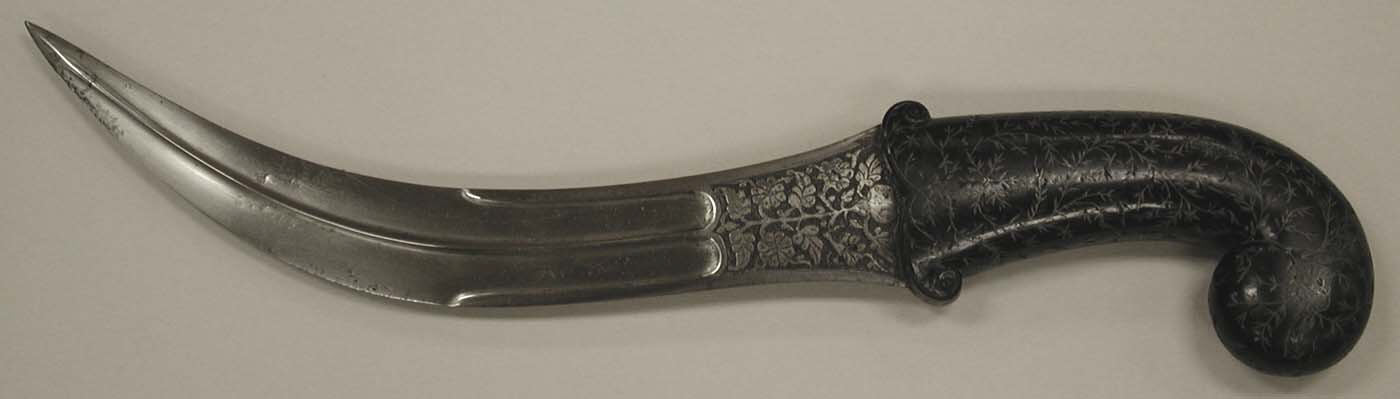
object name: dagger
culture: indian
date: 1801-1900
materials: jade